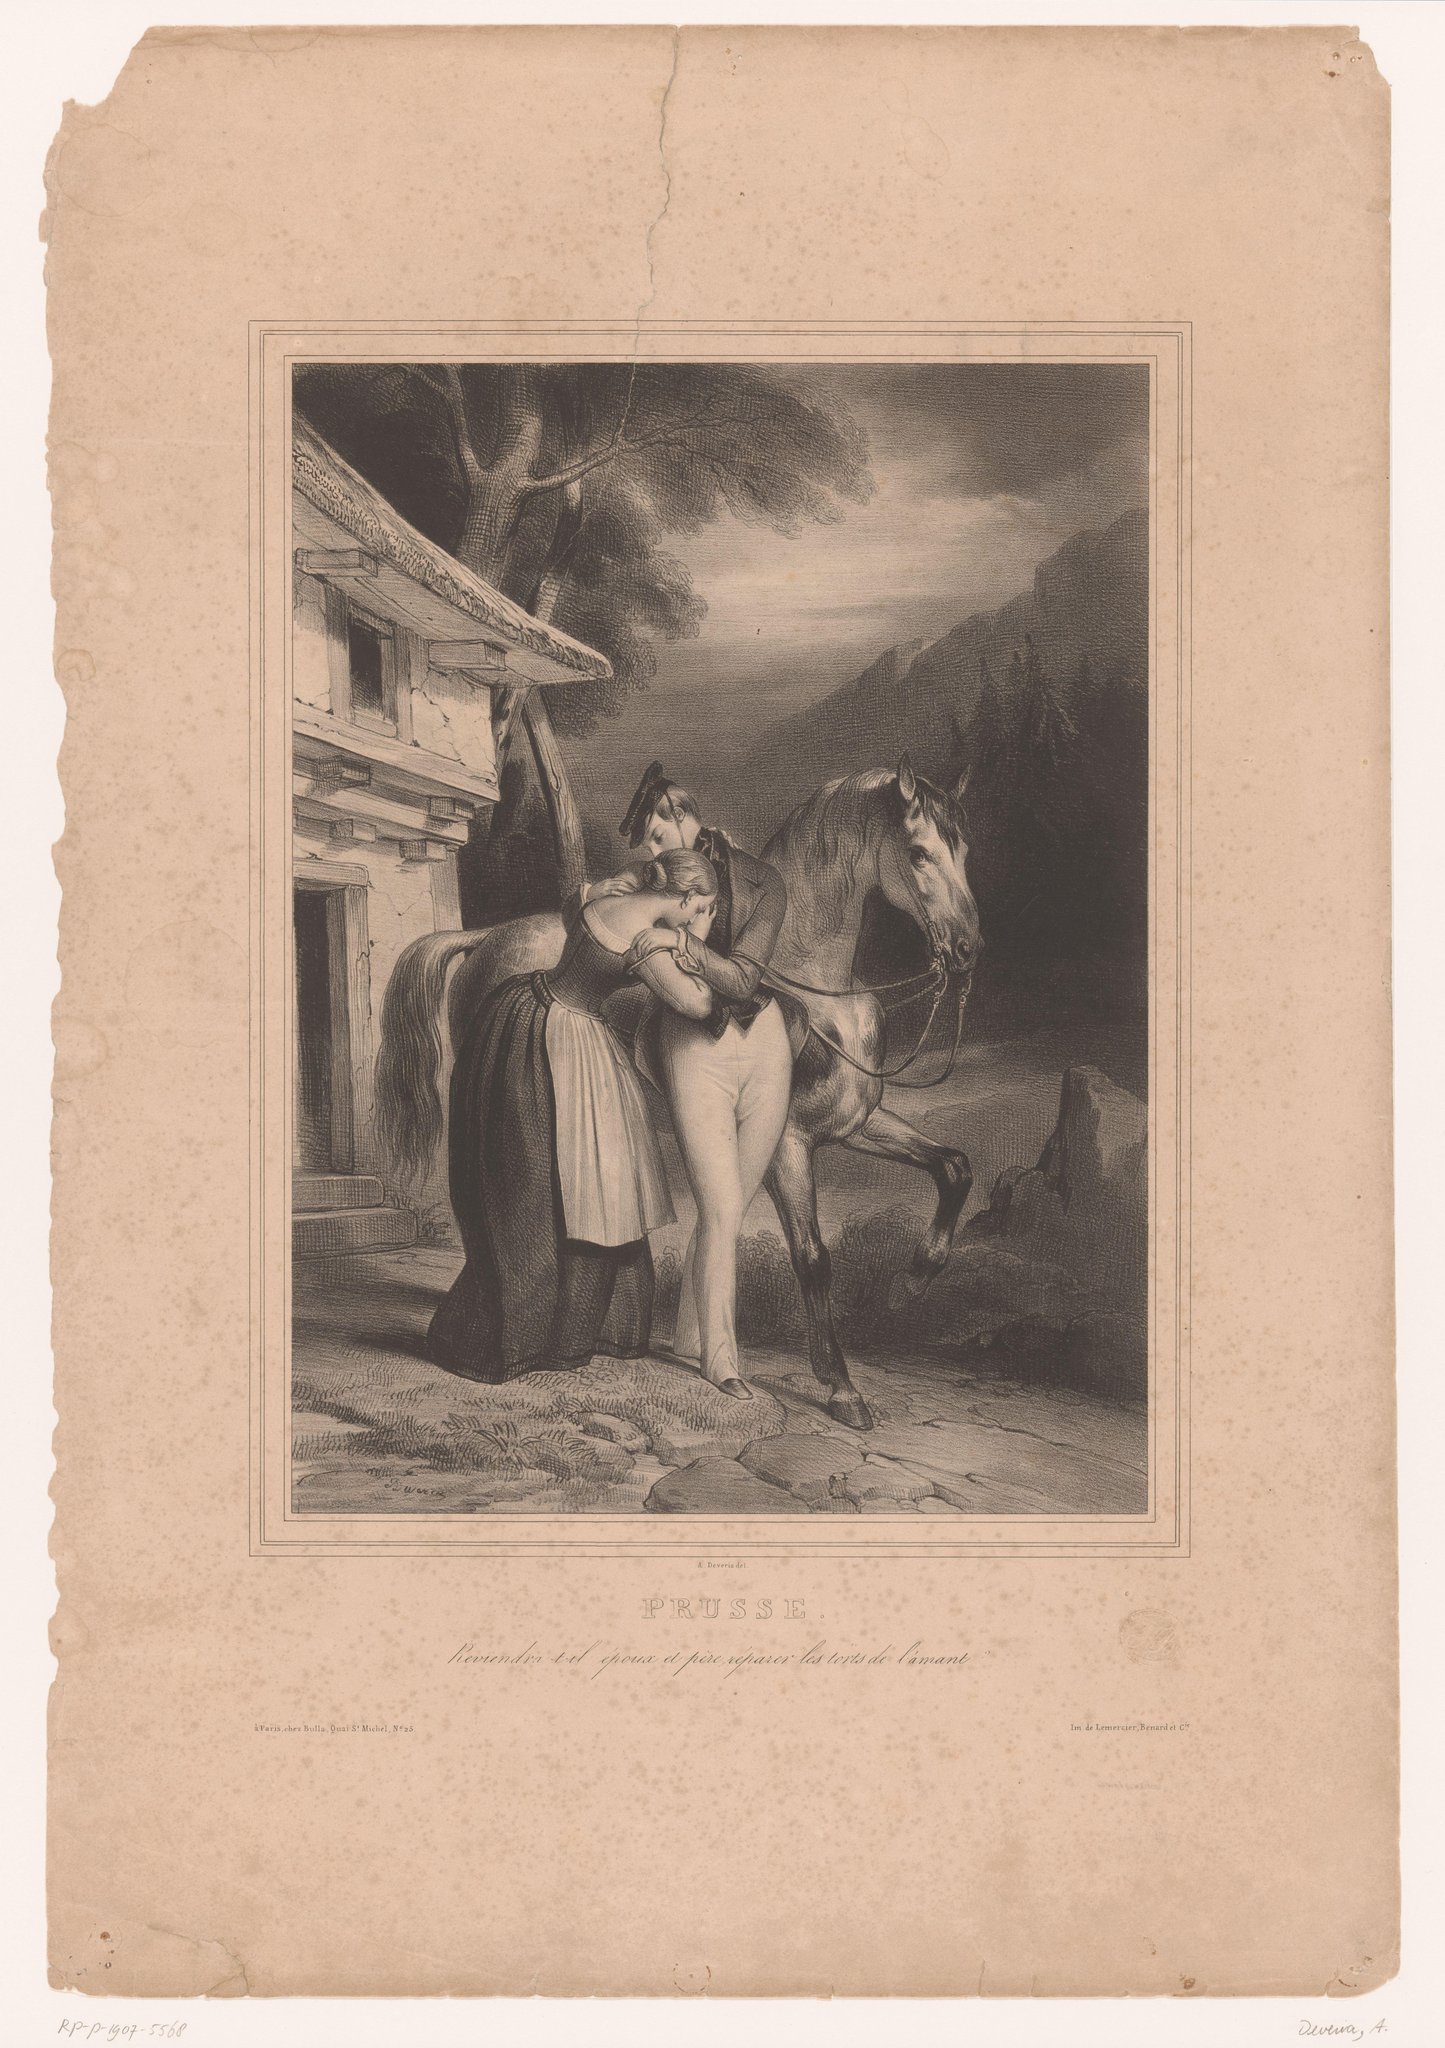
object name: print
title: Liefdesparen uit verschillende landen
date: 1834-1838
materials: paper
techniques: lithograph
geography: paris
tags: departure to join unit, company ~ military service, parting, leave-taking (of lovers), taking leave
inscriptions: check stamp: Lugt 4088, collector's mark: Lugt 2228a